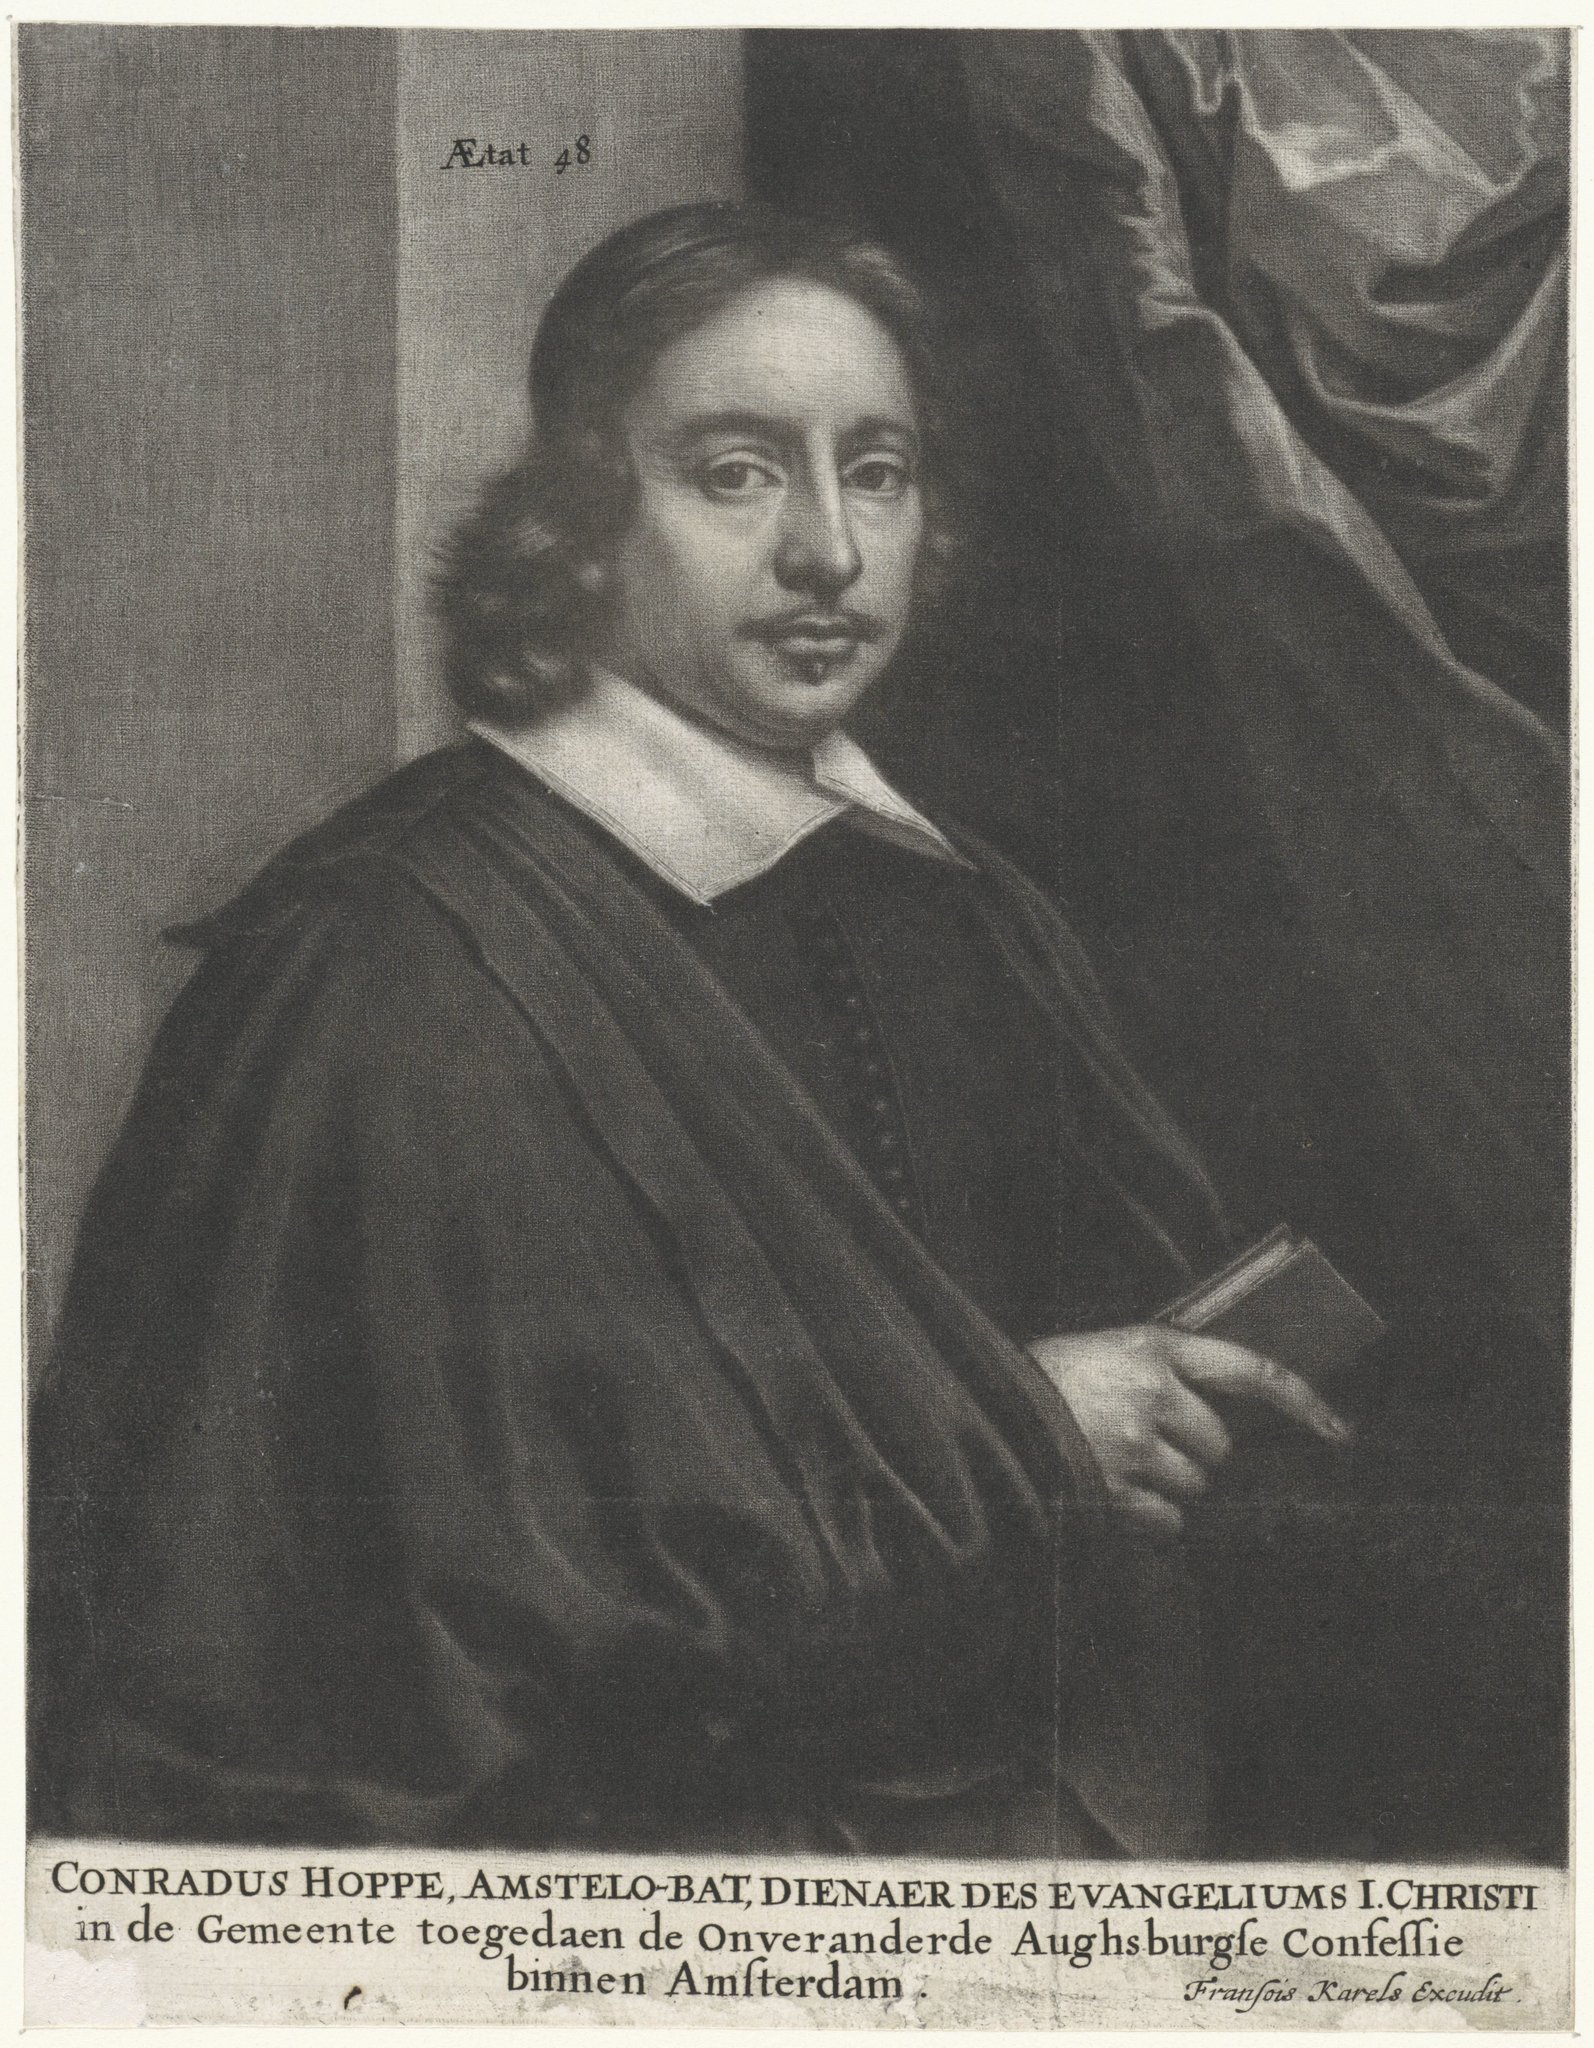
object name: print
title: Portret van Conradus Hoppe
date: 1658-1677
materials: paper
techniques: mezzotint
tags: book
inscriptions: collector's mark: Lugt 2228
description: De predikant Conradus Hoppe op 48-jarige leeftijd. Hij heeft een boek in zijn handen.